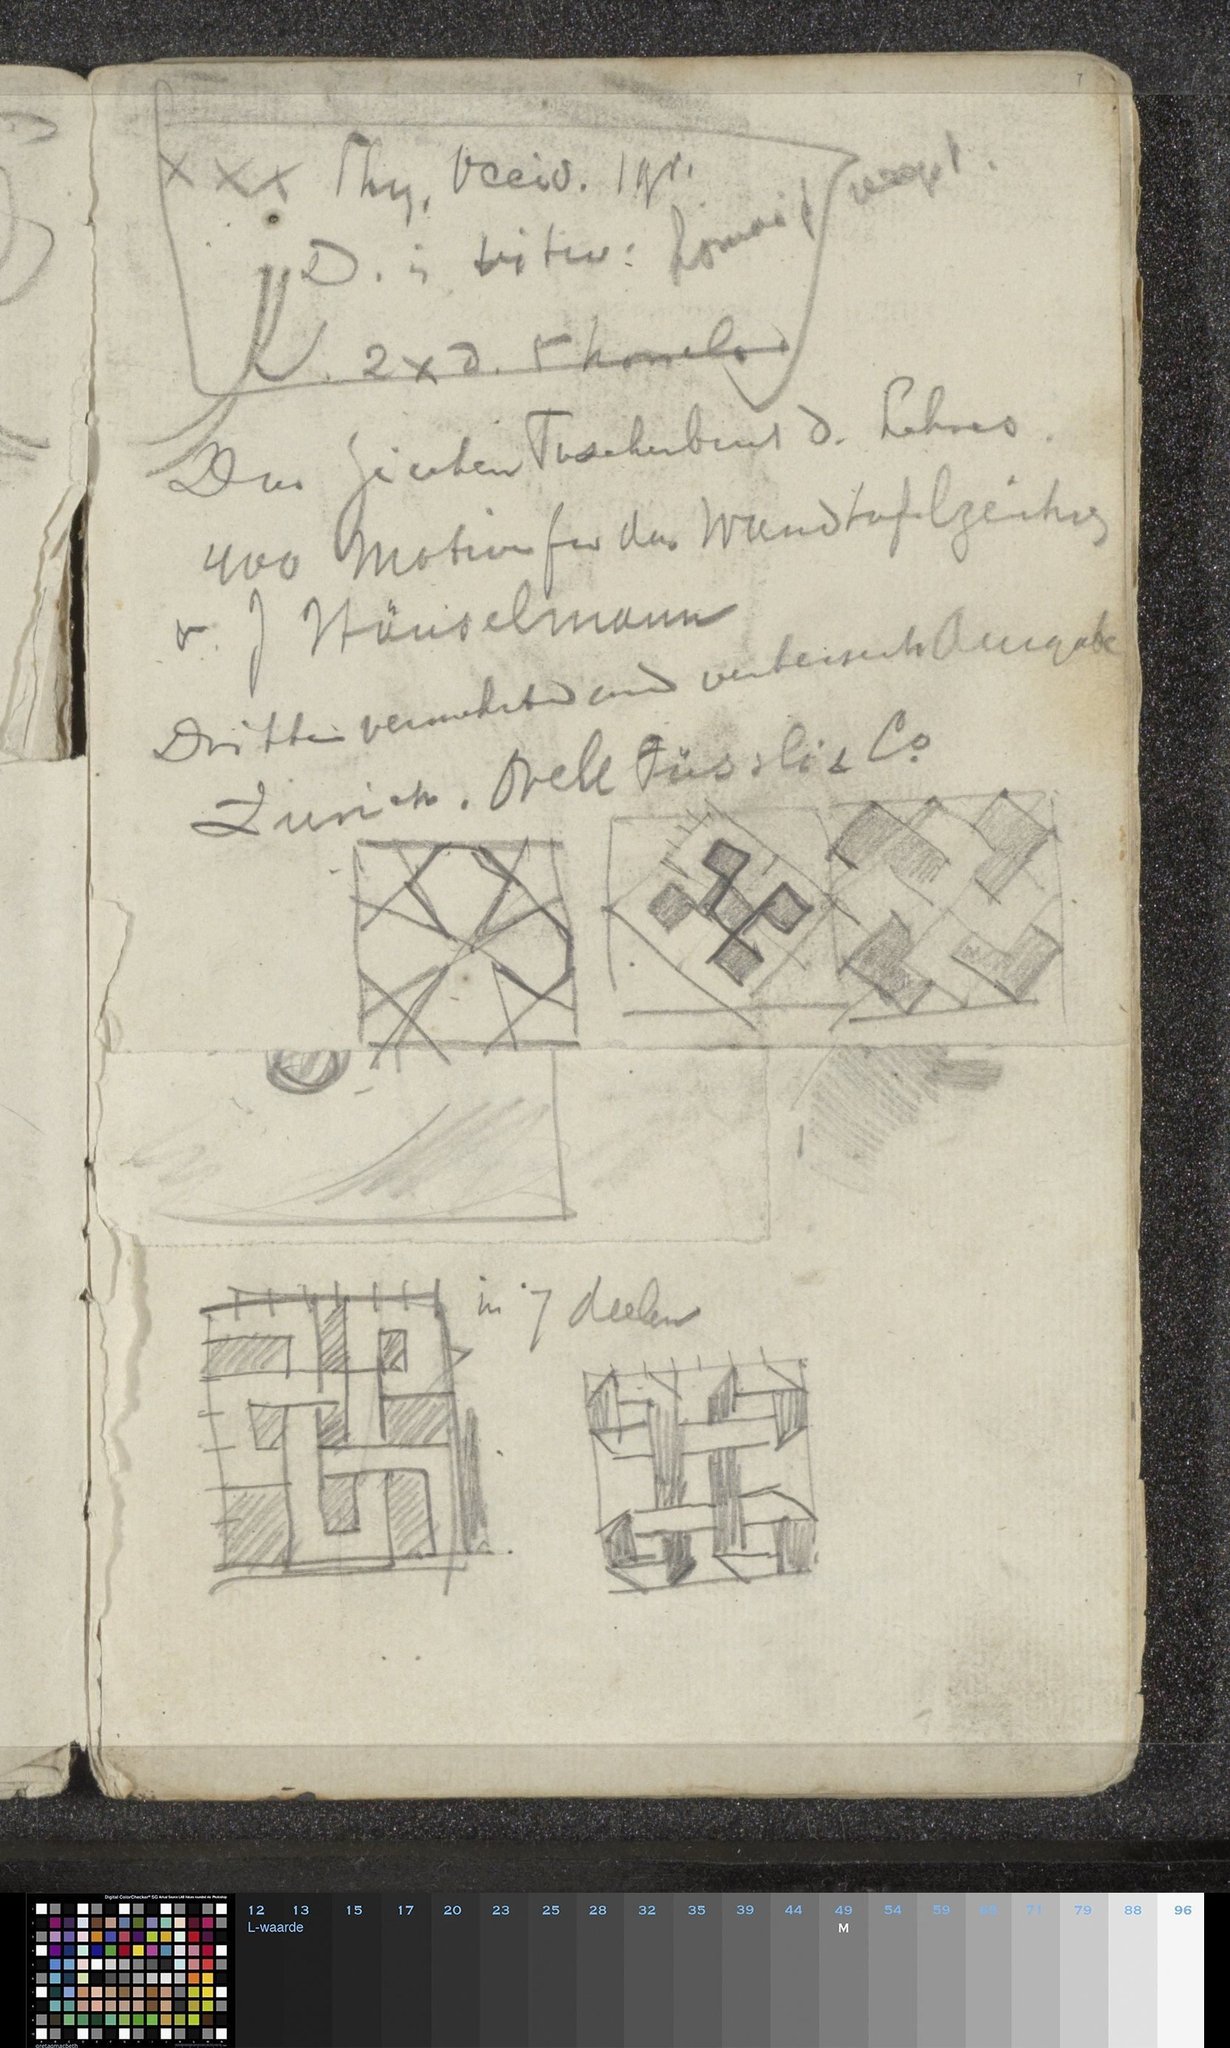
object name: sketchbook leaf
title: Studieblad met geometrische patronen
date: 1881-1883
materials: paper, pencil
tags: ornament ~ geometric motifs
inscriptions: annotation: ‘[...]/ Das Zeichen Taschenbuch d. Lehrers./ 400 Motive für das Wandtafelzeichnen/ v. J. Häuselmann/ Dritte vermehrte und verbesserte Ausgabe/ Zürich, Orell Füssli & Co.’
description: Pagina 7 uit een schetsboek met 29 bladen.